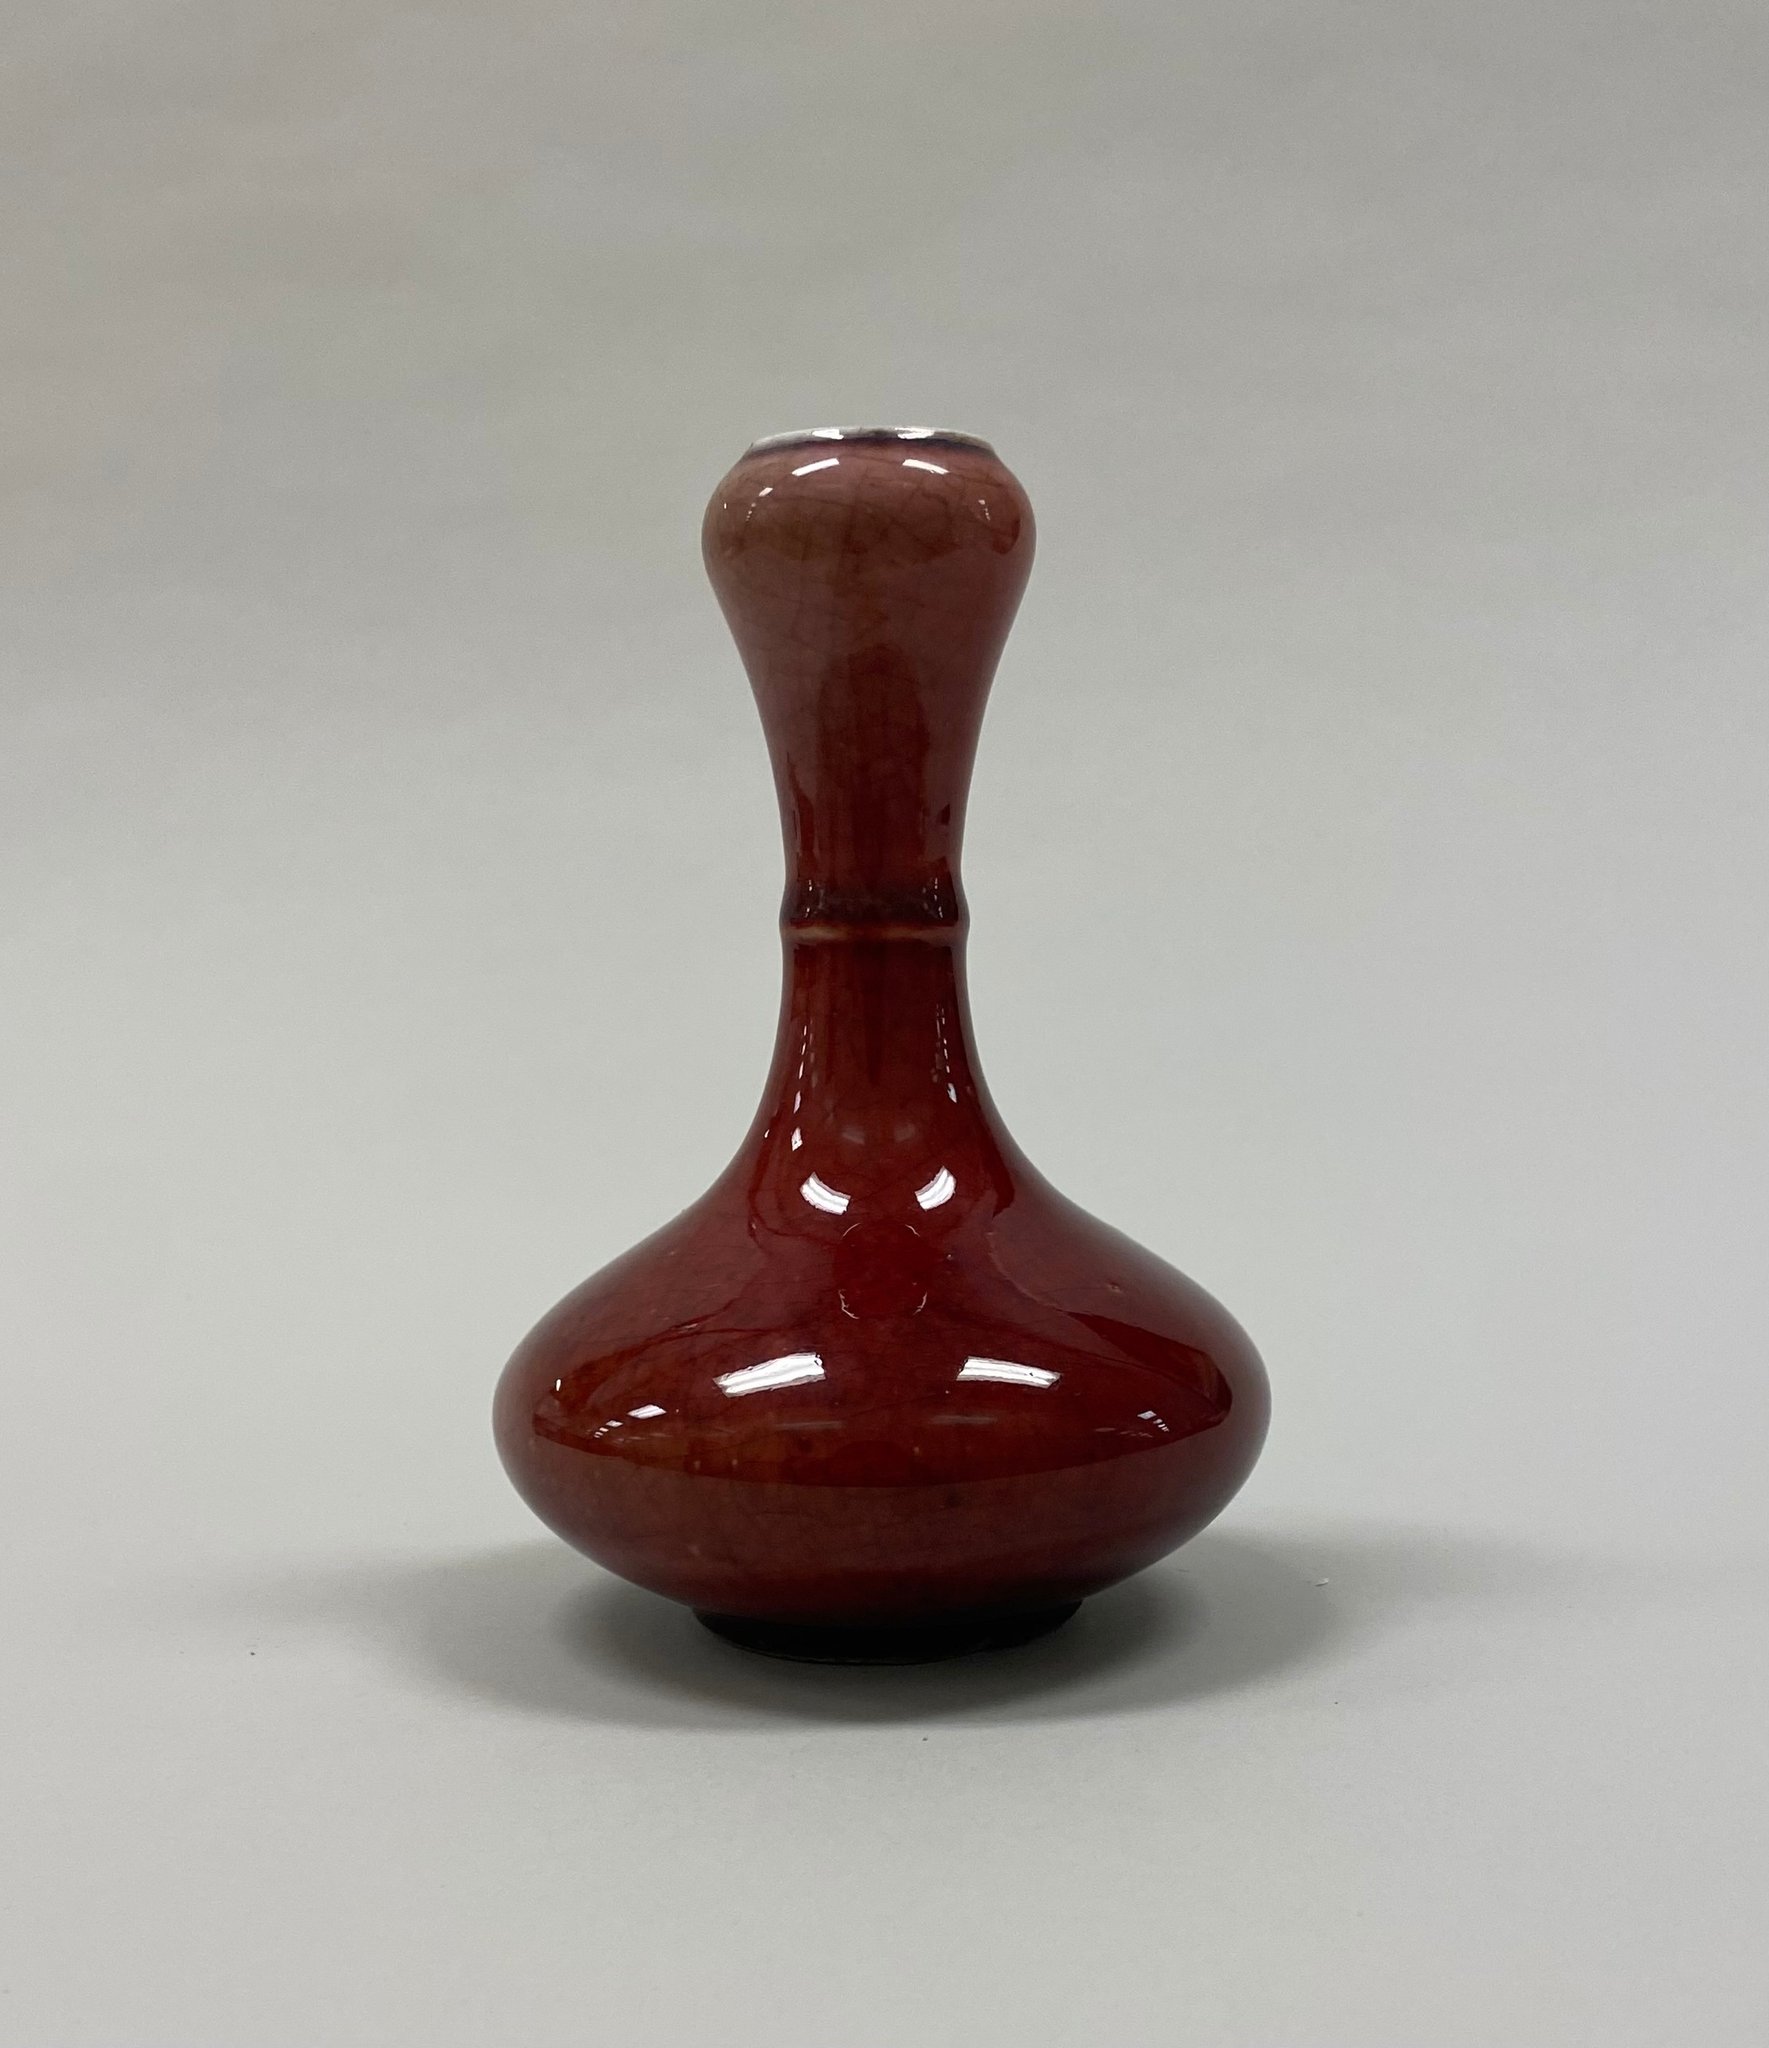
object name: vase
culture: chinese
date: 1701-1800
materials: copper, glaze, porcelain